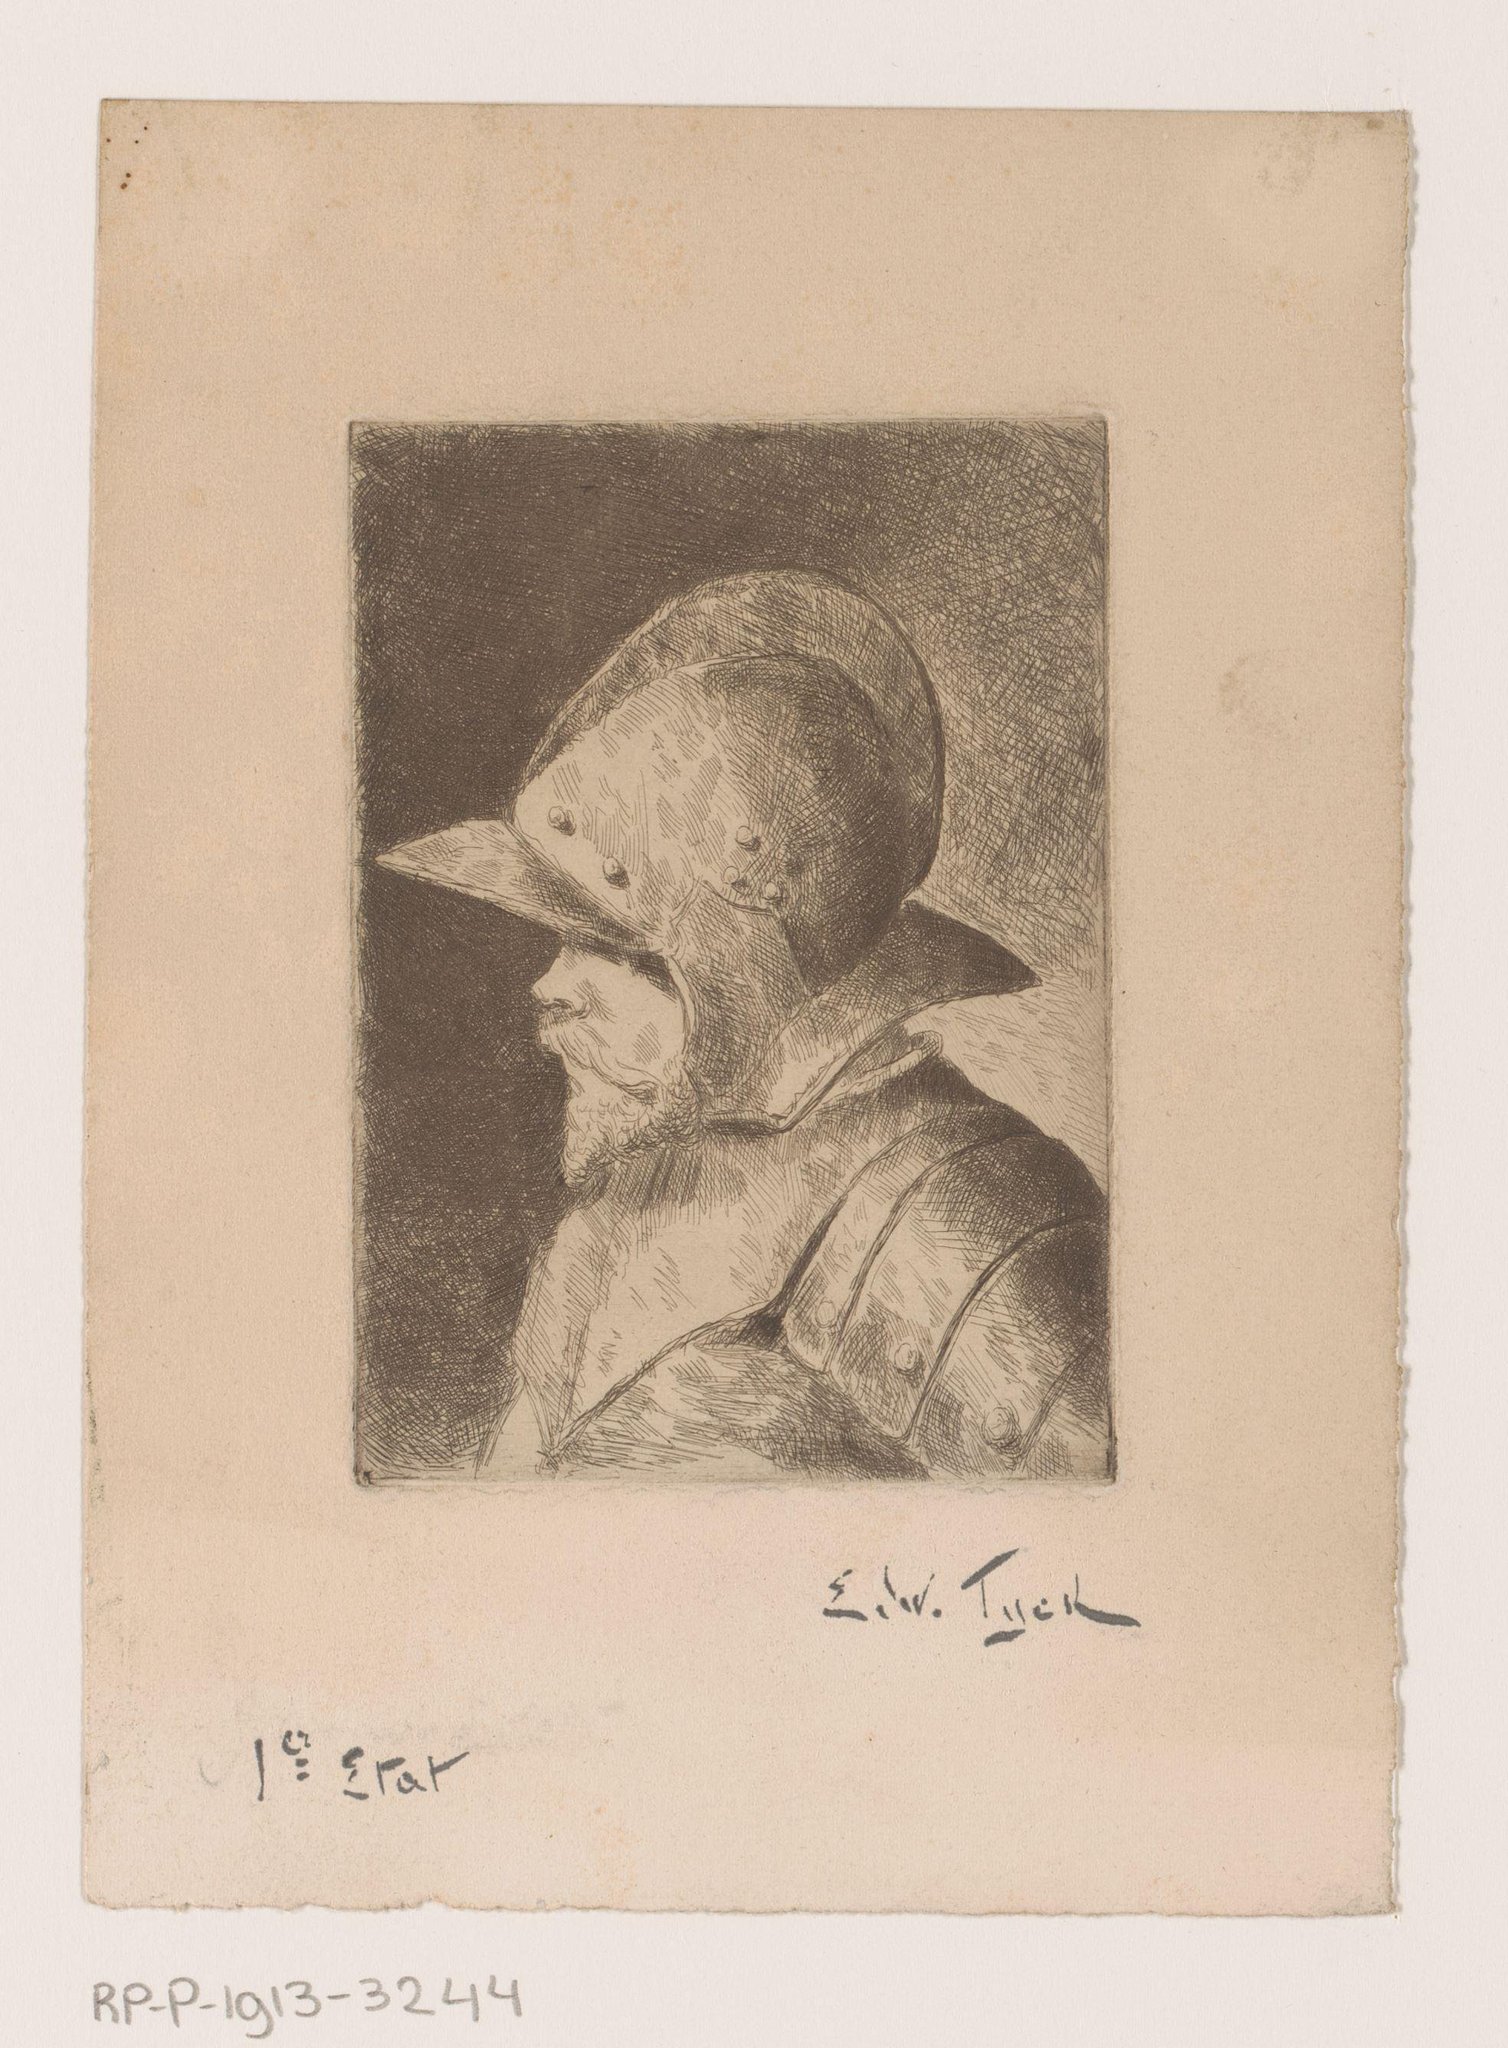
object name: print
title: Man in harnas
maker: edouard tyck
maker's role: print maker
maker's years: 1847-1922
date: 1857-1913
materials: paper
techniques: drypoint, etching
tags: armour, adult man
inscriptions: collector's mark: Lugt 2228